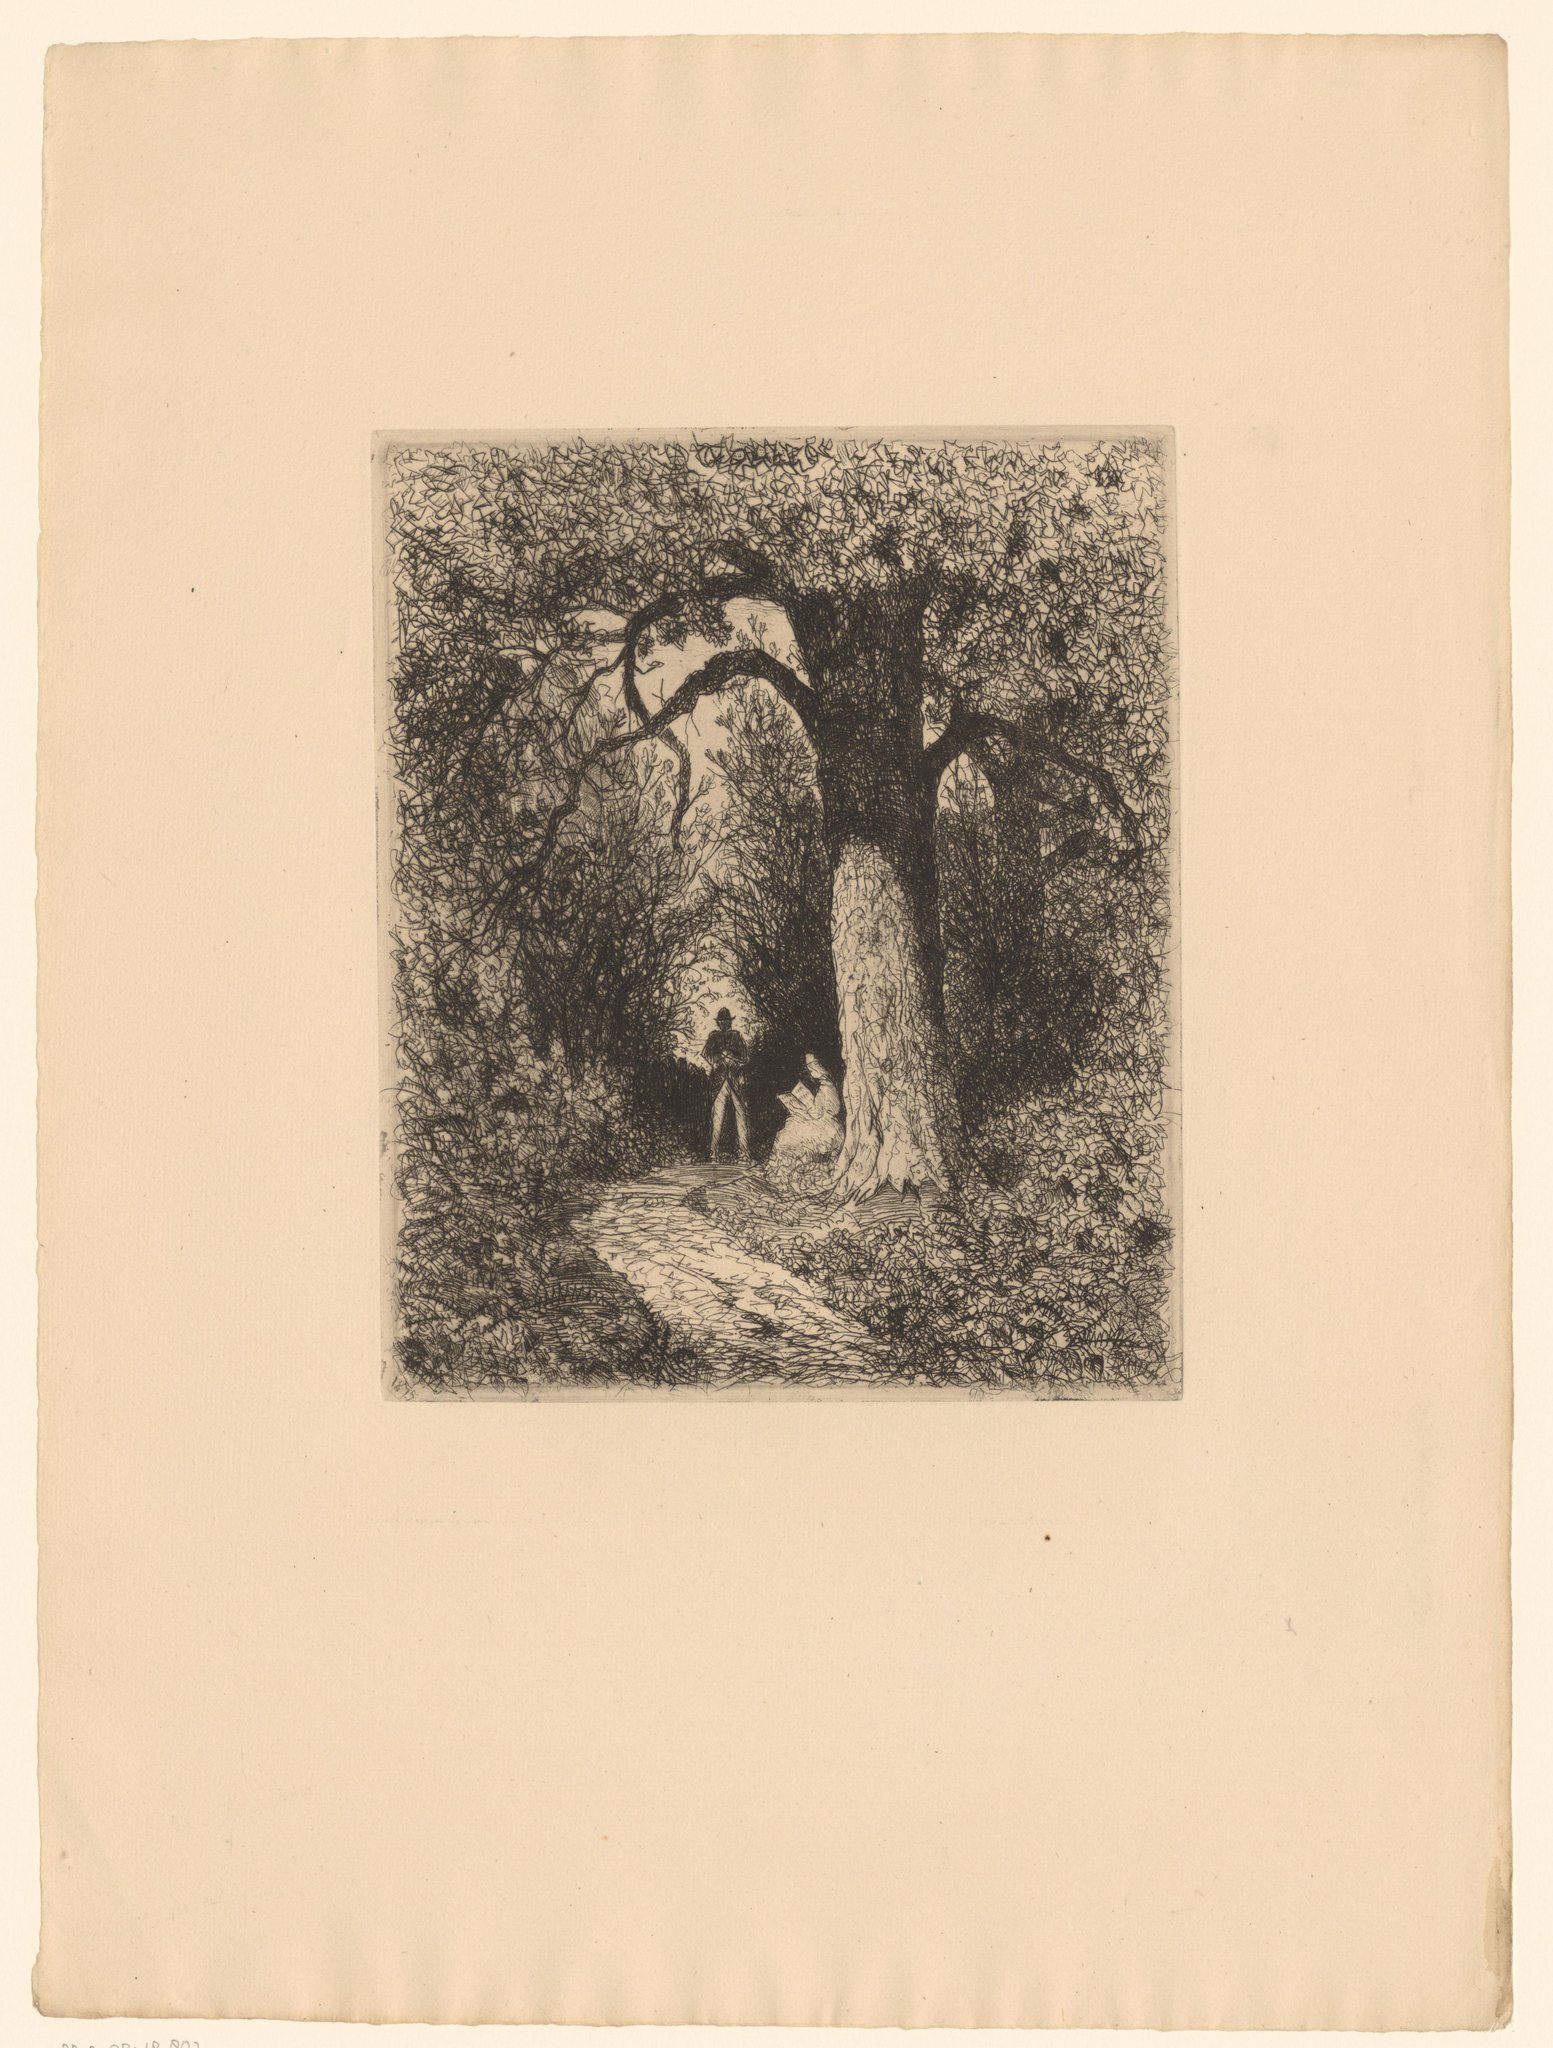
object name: print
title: Bospad met wandelaar en lezende vrouw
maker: willes johnson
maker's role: print maker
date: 1875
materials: paper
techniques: etching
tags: forest path or lane (+ landscape with figures, staffage)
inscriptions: collector's mark: Lugt 2228